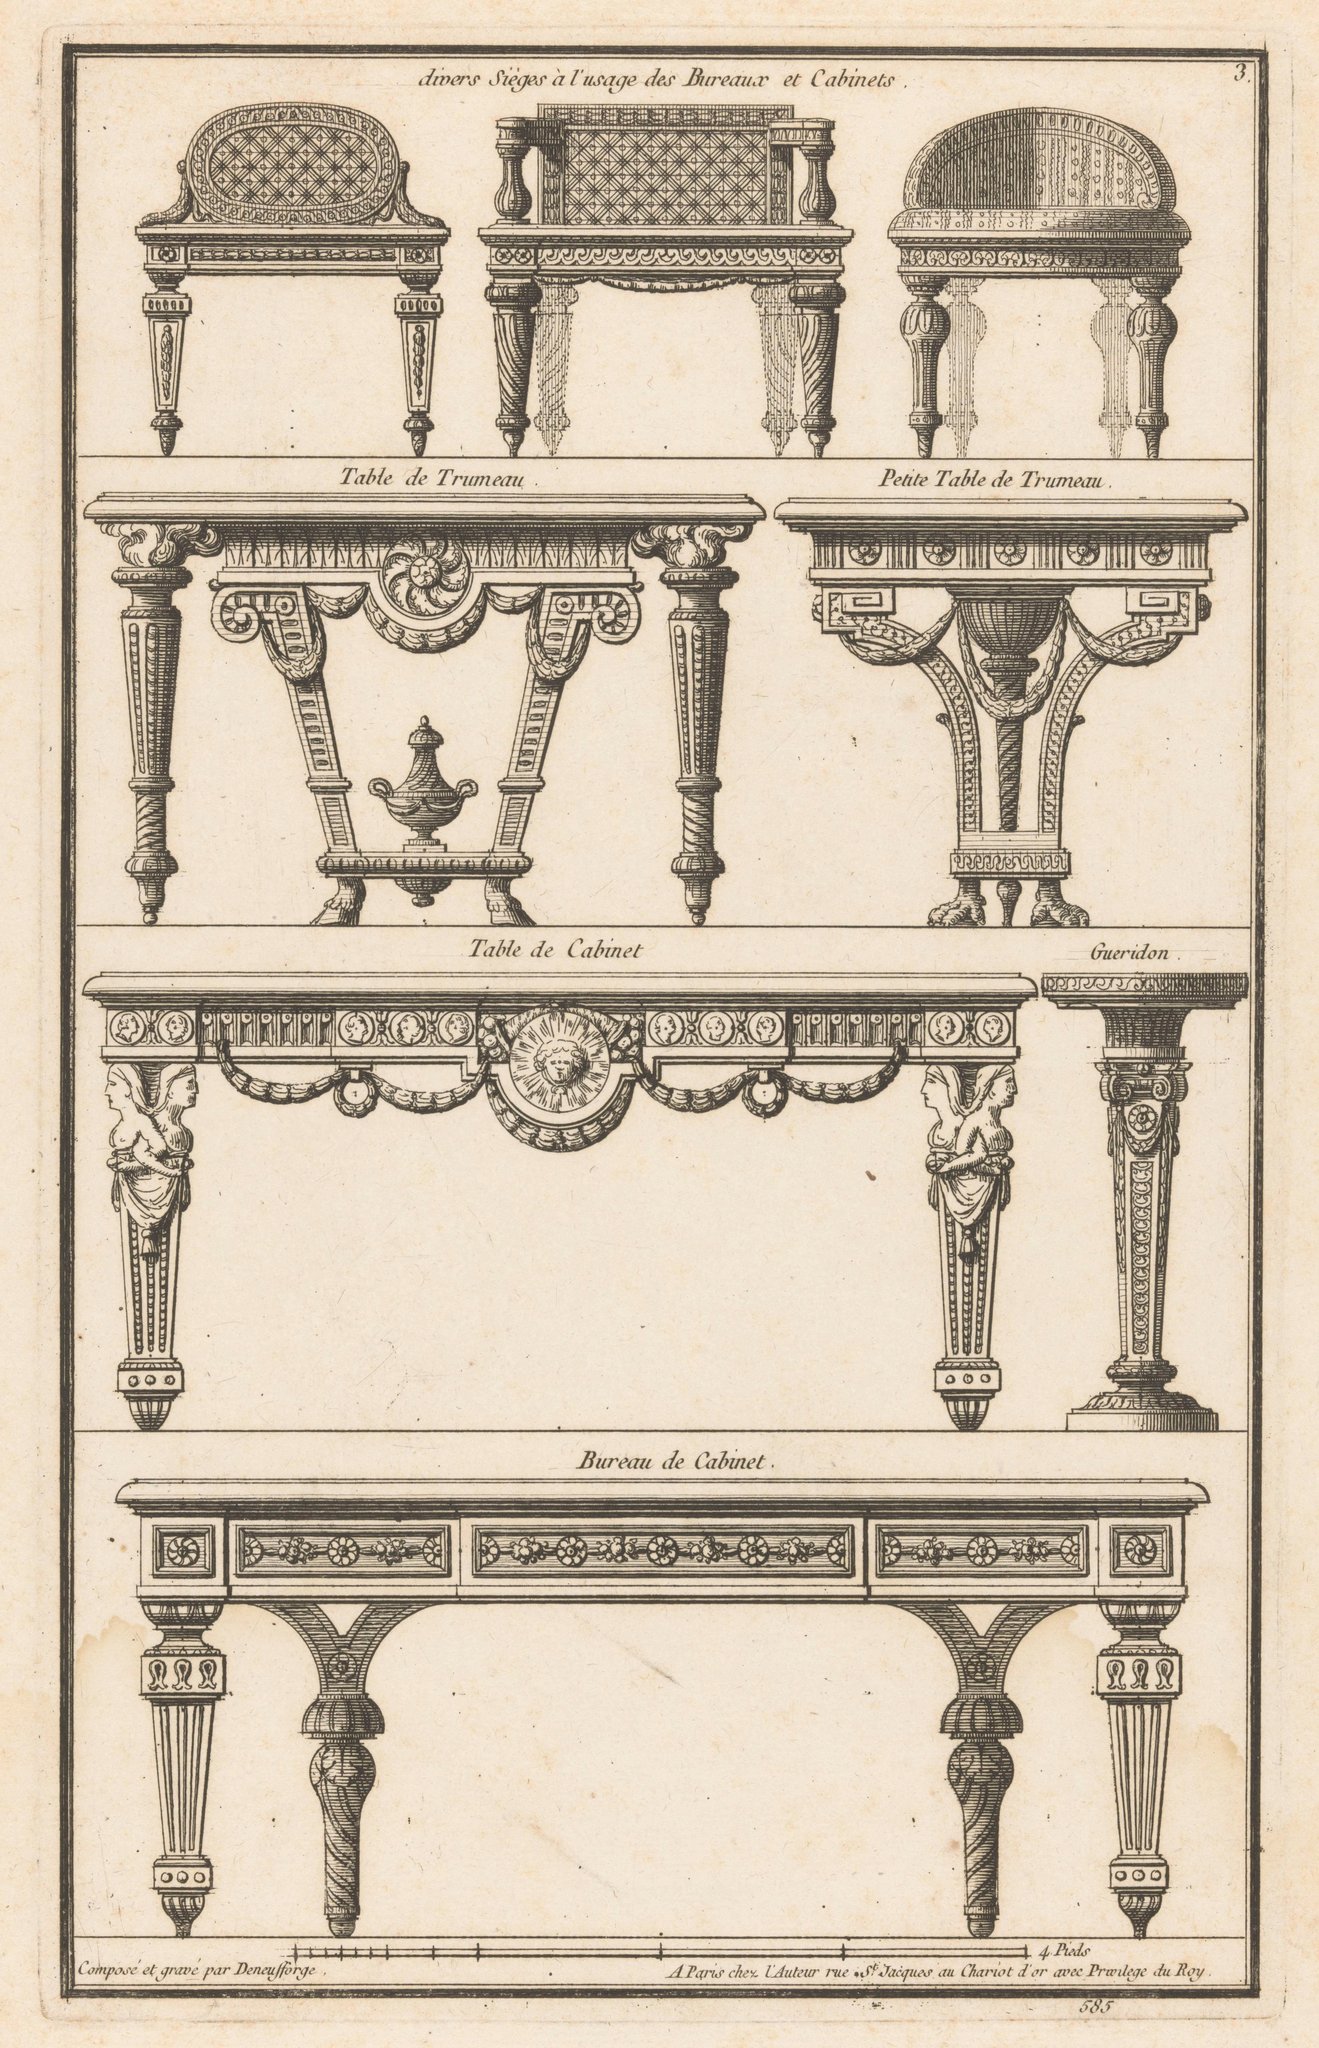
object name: print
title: divers Sièges à l'usage des Bureaux et Cabinets, Table de Trumeau, Petite Table de Trumeau, Table de Cabinet, Gueridon, Bureau de Cabinet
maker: jean françois de neufforge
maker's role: print maker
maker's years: 1714-1791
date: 1767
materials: paper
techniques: etching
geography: paris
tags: writing-table, writing-desk, table, chair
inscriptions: collector's mark: Lugt 2760, collector's mark: Lugt 2228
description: Drie geornamenteerde stoelen met ruitpatroon en bloemmotieven. Daaronder twee geornamenteerde tafels te plaatsen voor een trumeau. Daaronder links een geornamenteerde tafel met termen, guirlandes en een medaillon met de zon als gezicht en rechts een gueridon. Aan de onderzijde een geornamenteerd bureau met bloemmotieven. Prentnummer 585.